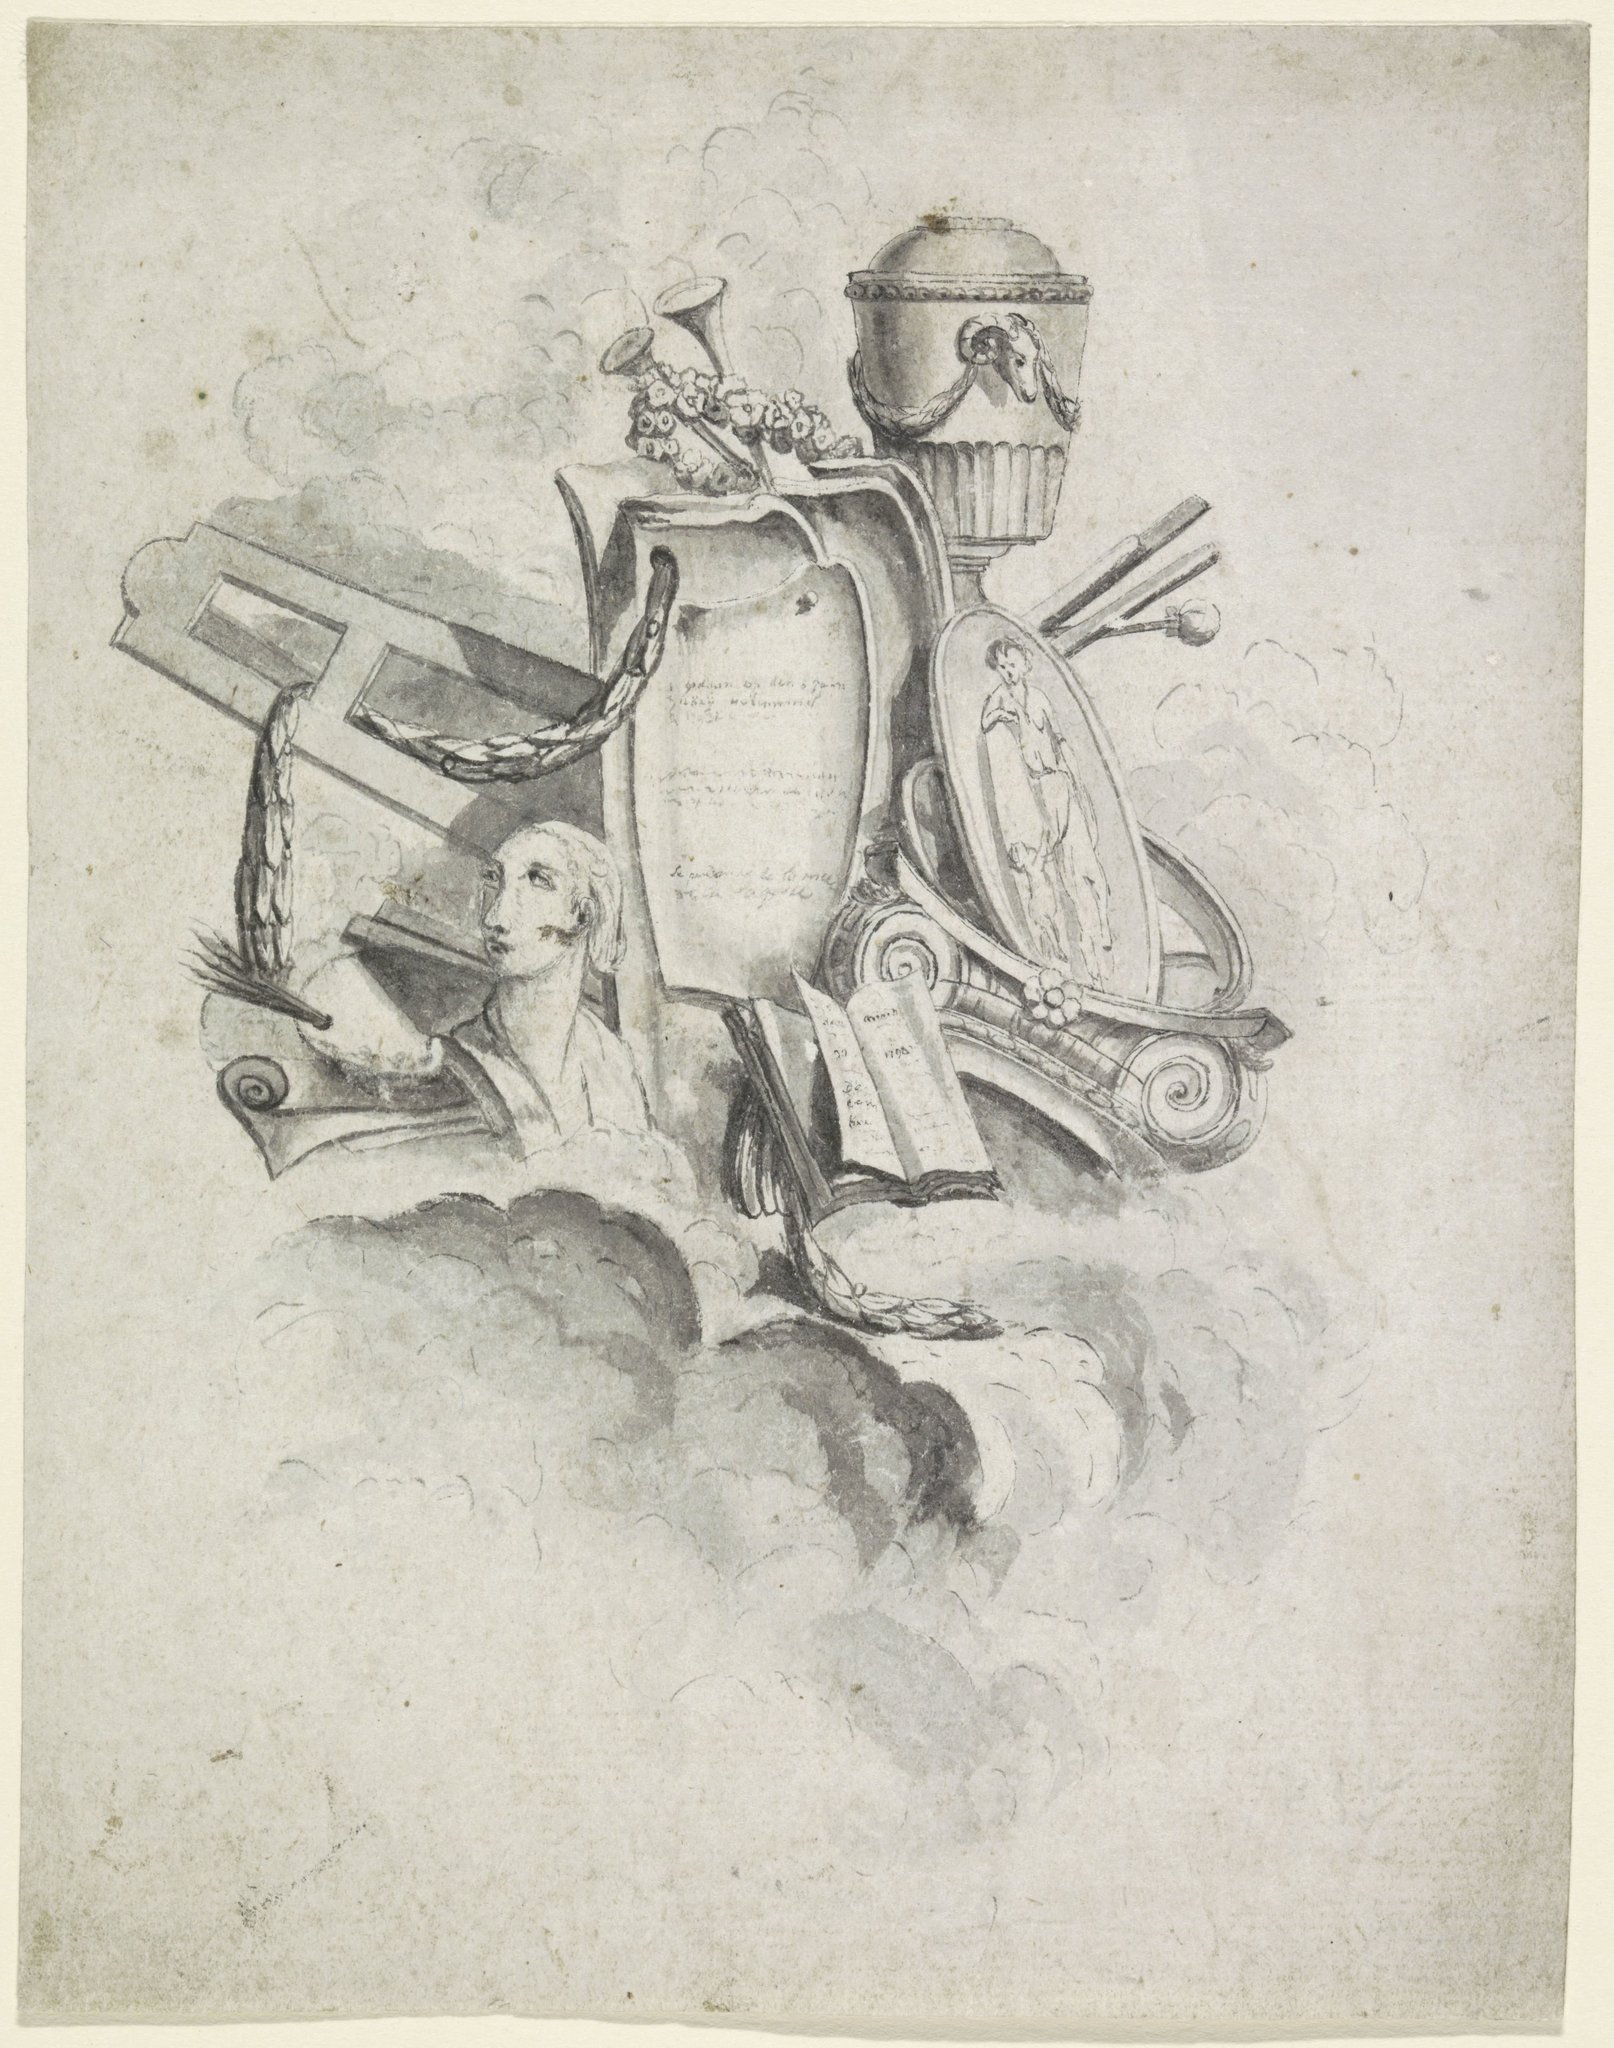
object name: drawing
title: Trofee met attributen behorende bij de kunsten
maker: Anonymous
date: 1747-1800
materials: ink, paper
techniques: brush, pen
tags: the arts; artists, trophy, i.e.: decorative arrangement of symbolic or typical objects ~ ornament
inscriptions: collector's mark: Lugt 2228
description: Een trofee met attributen behorende bij de kunsten zoals een schildersezel, een schilderspalet, een buste, een boek, een medaillon, een kapiteel, een vaas en in het midden een cartouche.